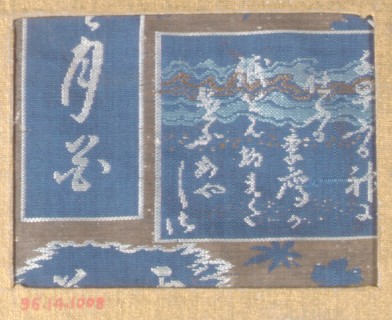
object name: piece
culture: japanese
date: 1701-1900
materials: silk